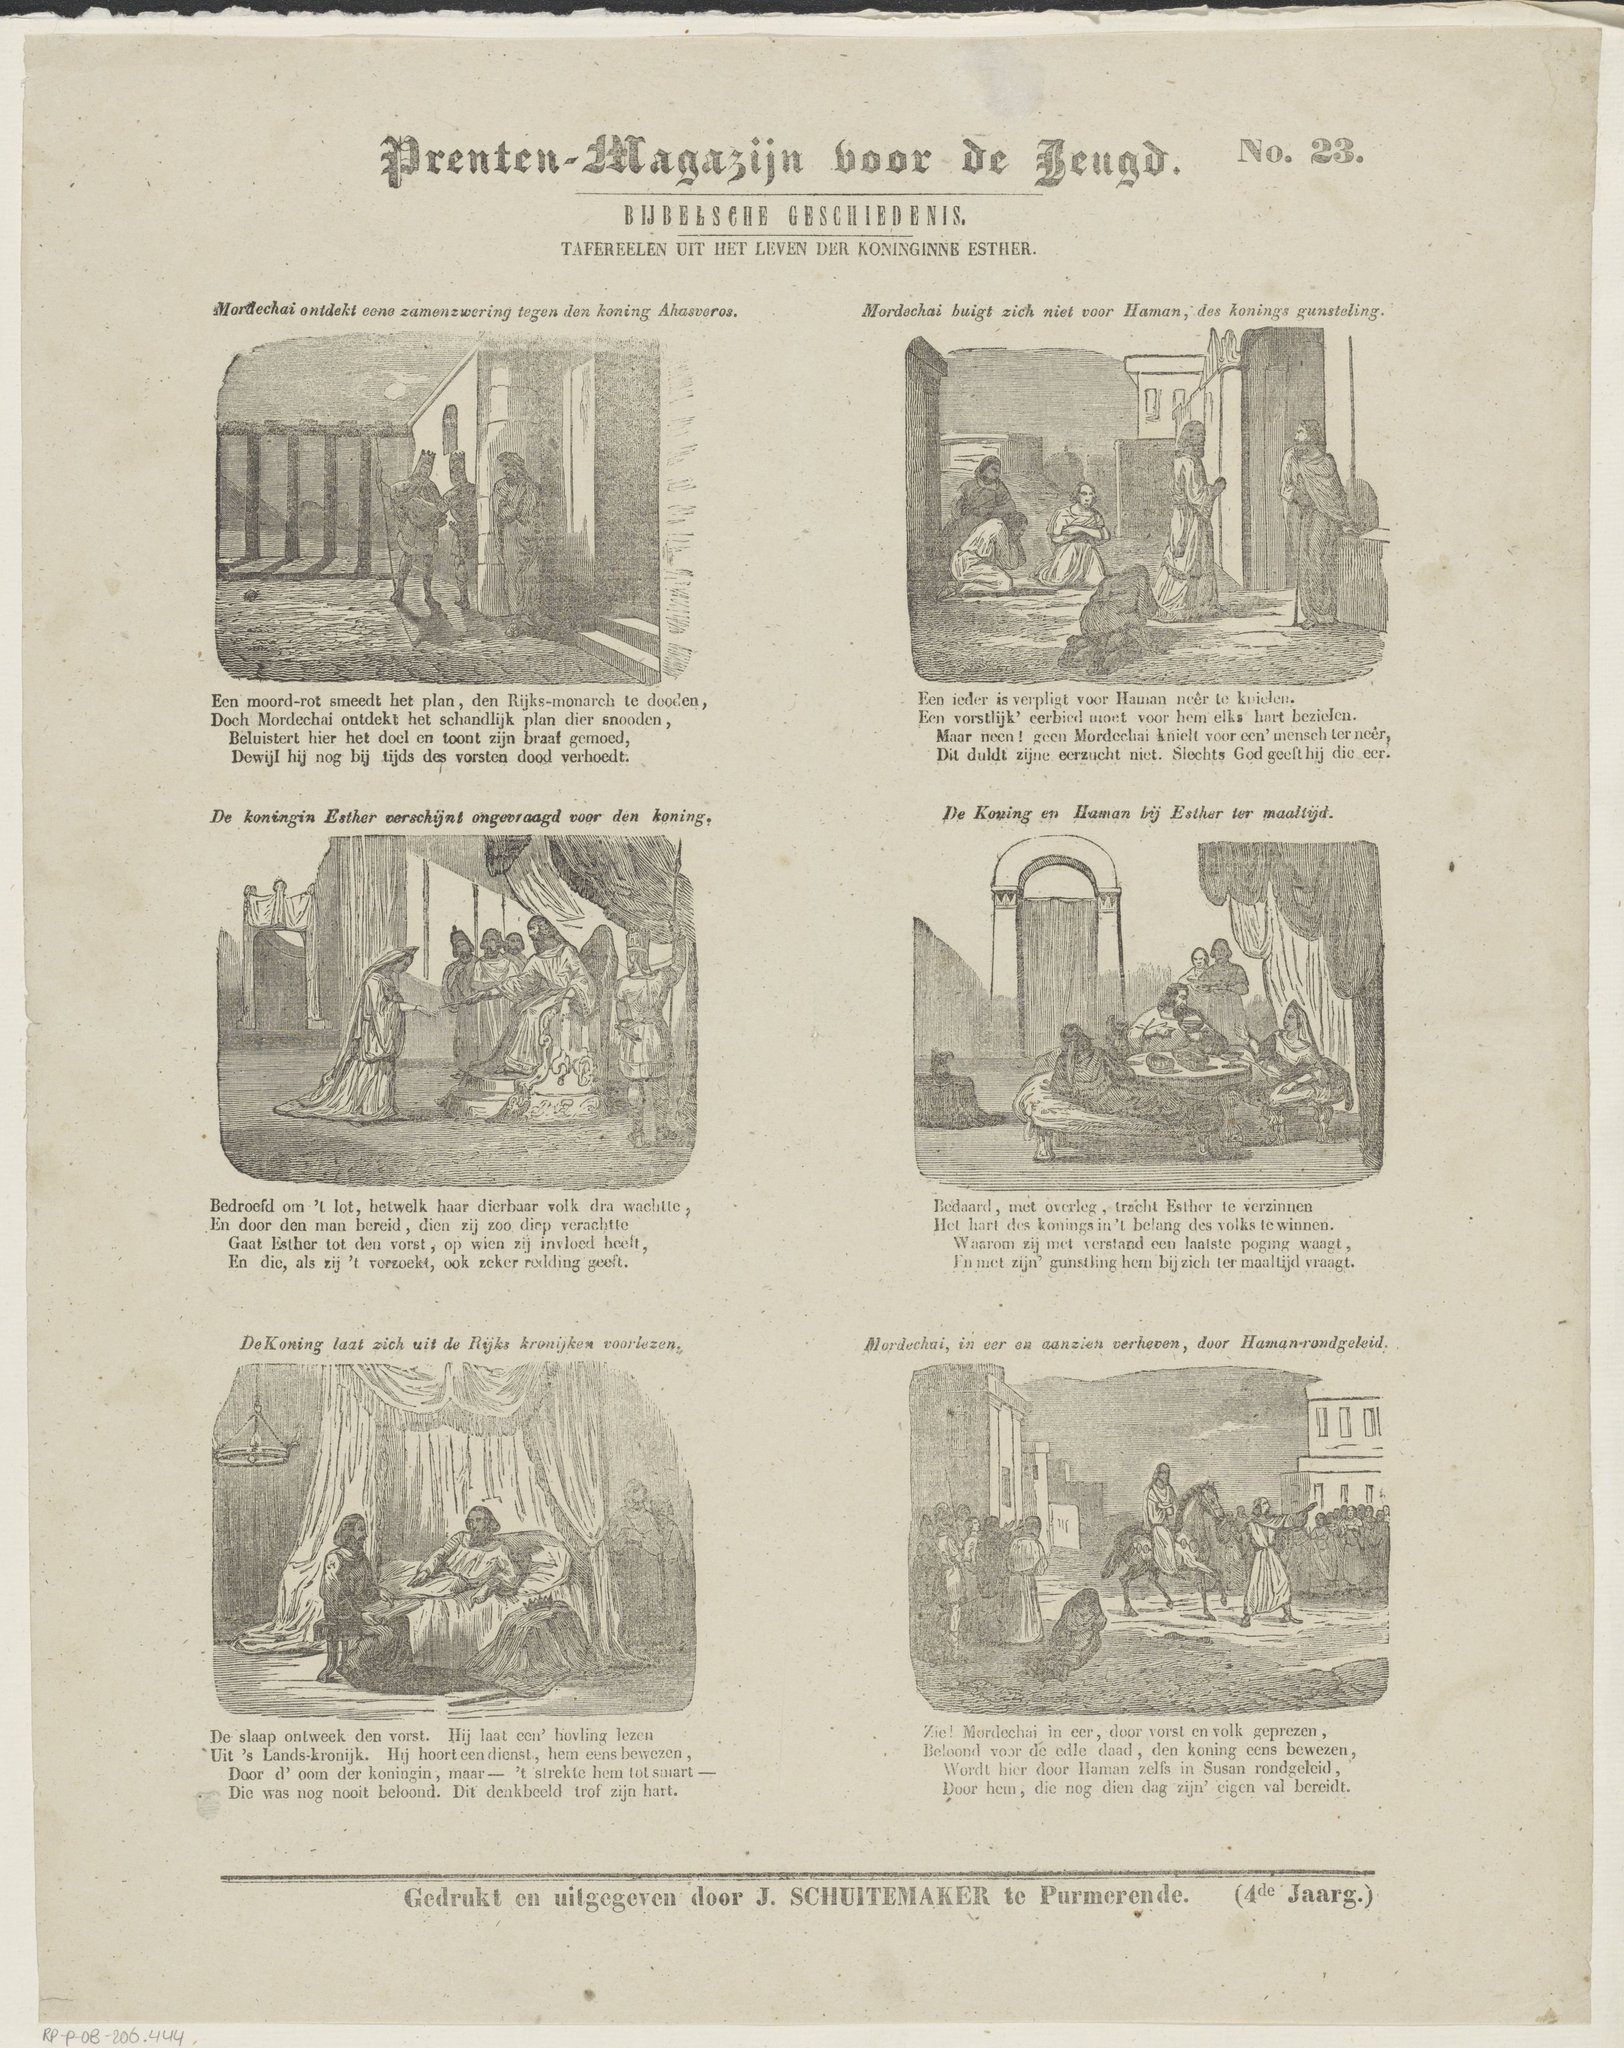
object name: popular print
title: Bijbelsche geschiedenis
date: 1845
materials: paper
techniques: letterpress printing, engraving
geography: netherlands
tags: the story of esther, old testament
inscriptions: collector's mark: Lugt 2760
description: Blad met 6 voorstellingen uit het leven van de oudtestamentische koningin Ester. Boven elke voorstelling een titel en onder elke voorstelling een vierregelig vers. Genummerd rechtsboven: No. 23.